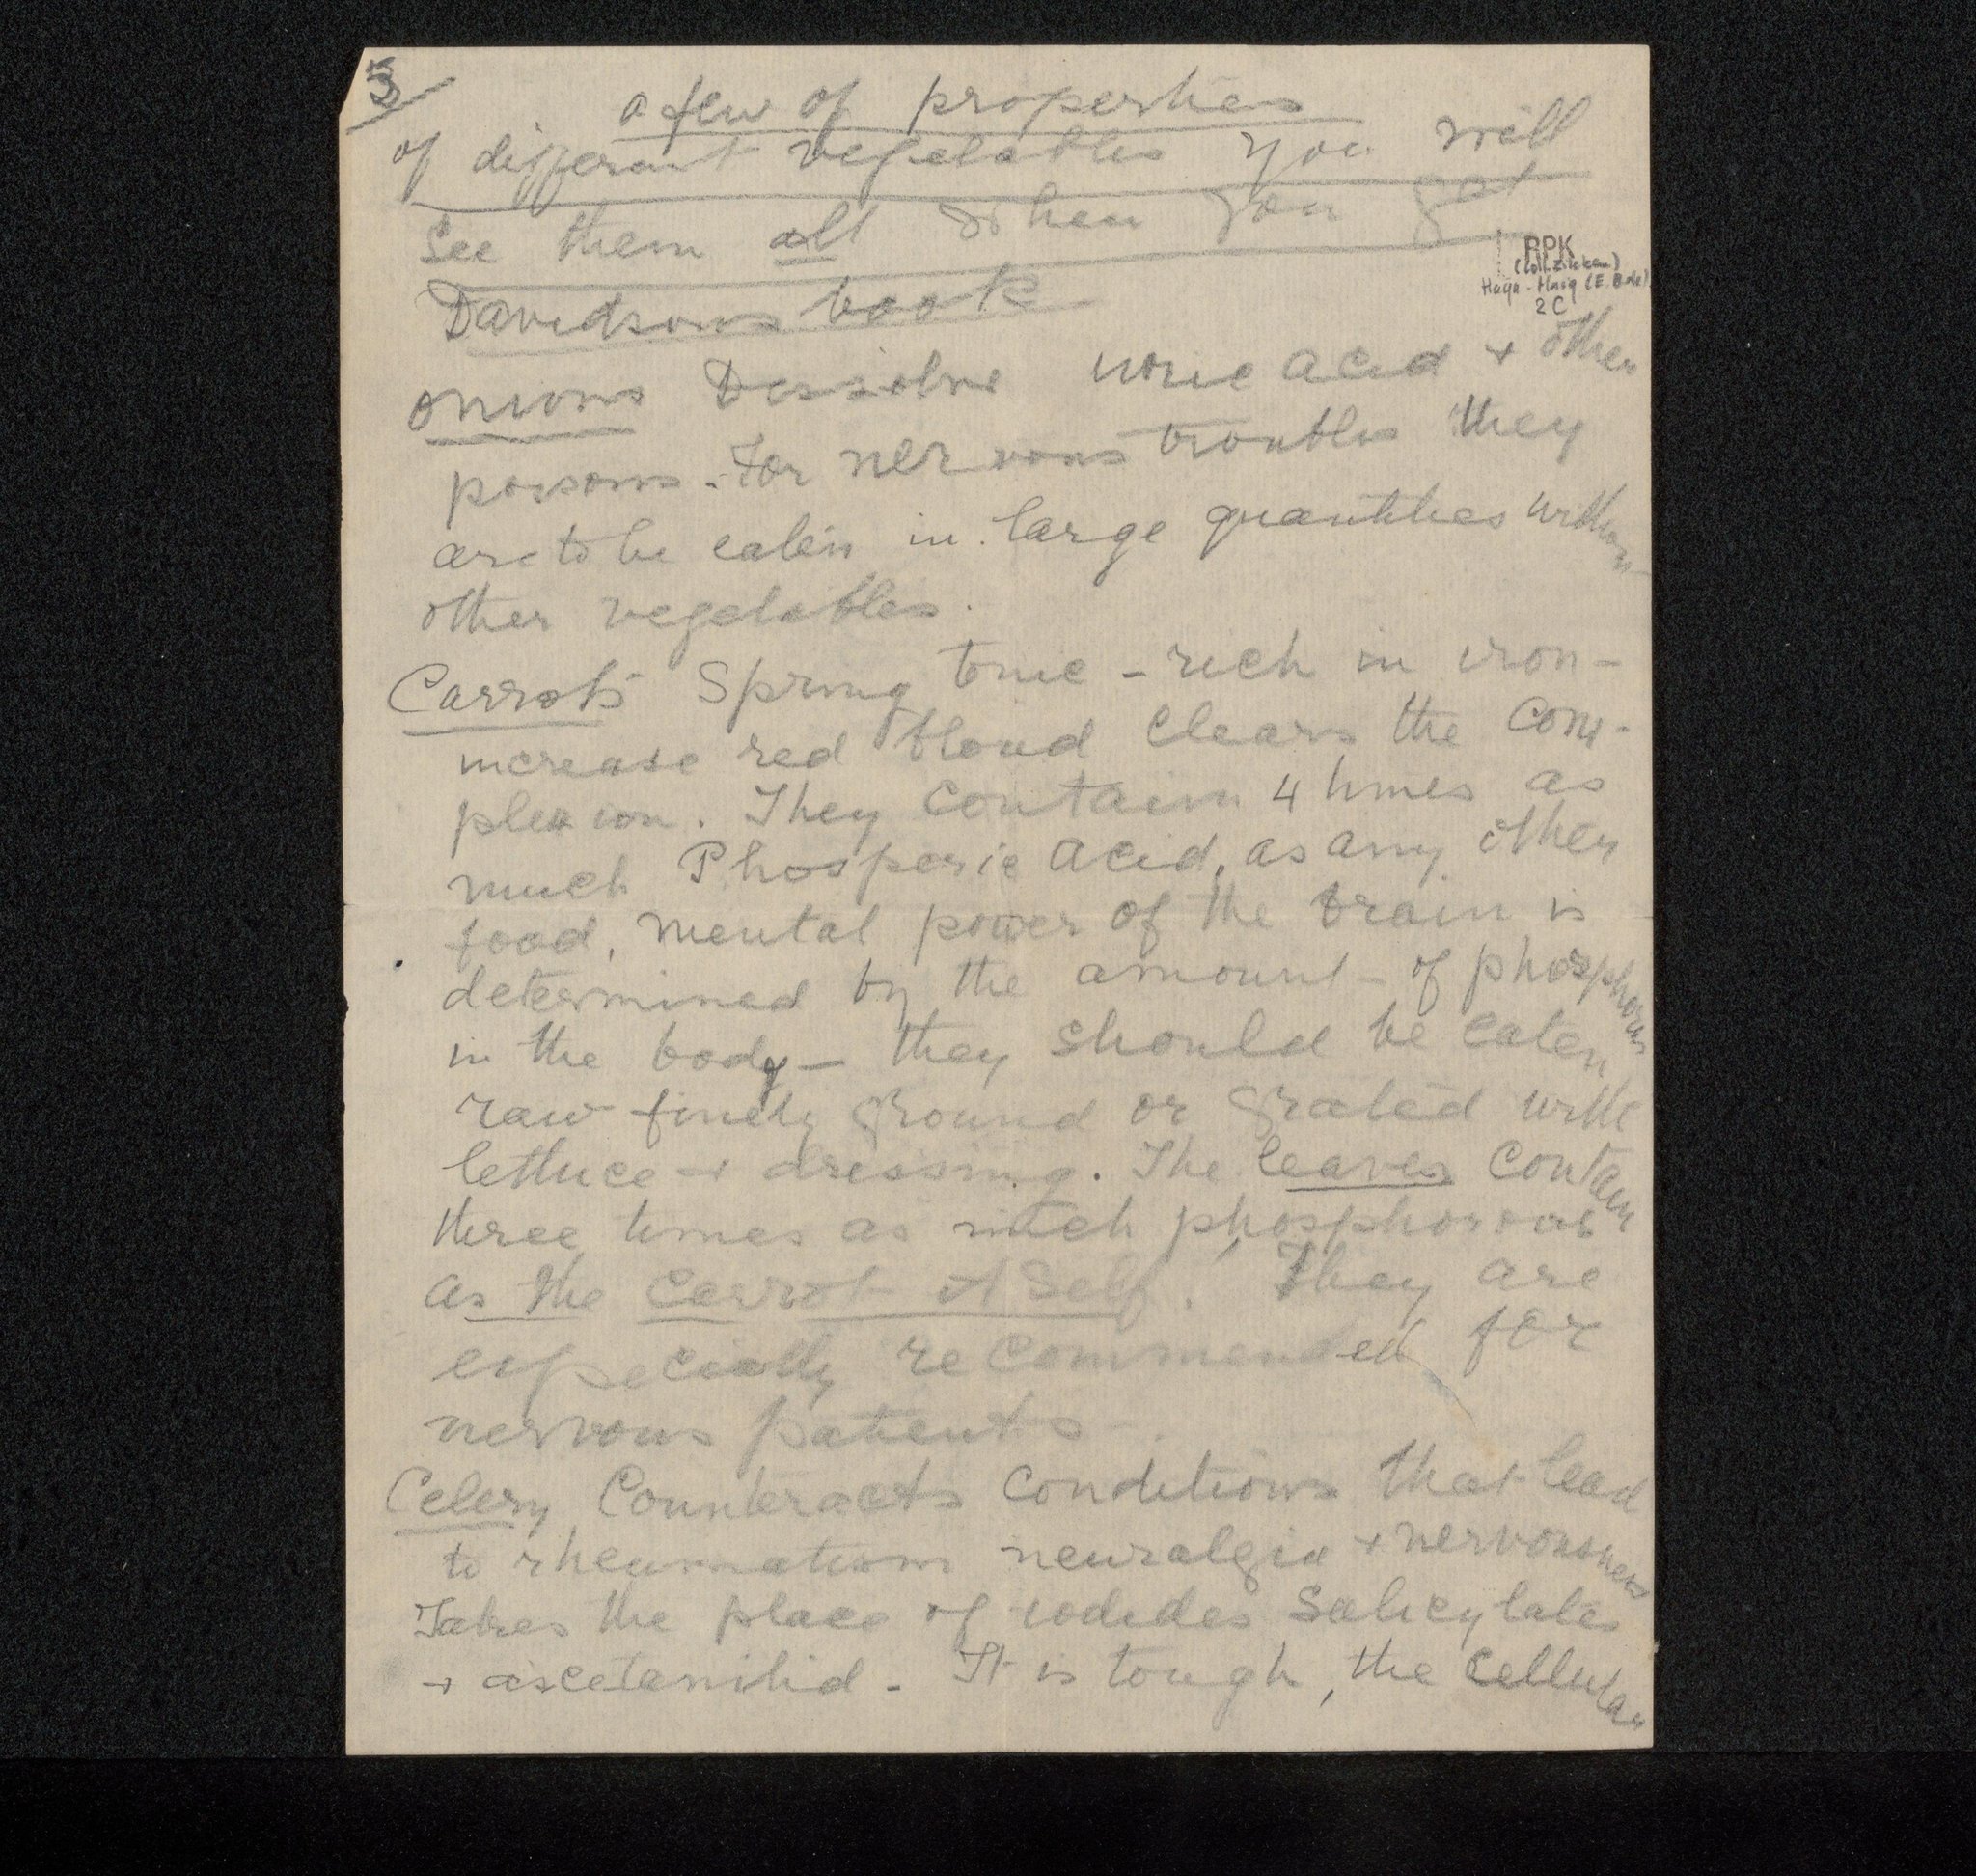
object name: letter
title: Brief aan Henriette Wilhelmina van Baak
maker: e. b. de haga haig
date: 1932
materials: paper, pencil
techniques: writing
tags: henriette wilhelmina van baak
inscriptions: collector's mark: ‘RPK’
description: Vormt samen met RP-D-1982-43-HAGA-HAIG(E.B.DE)-2A en RP-D-1982-43-HAGA-HAIG(E.B.DE)-2B en RP-D-1982-43-HAGA-HAIG(E.B.DE)-2D doorlopende brief.